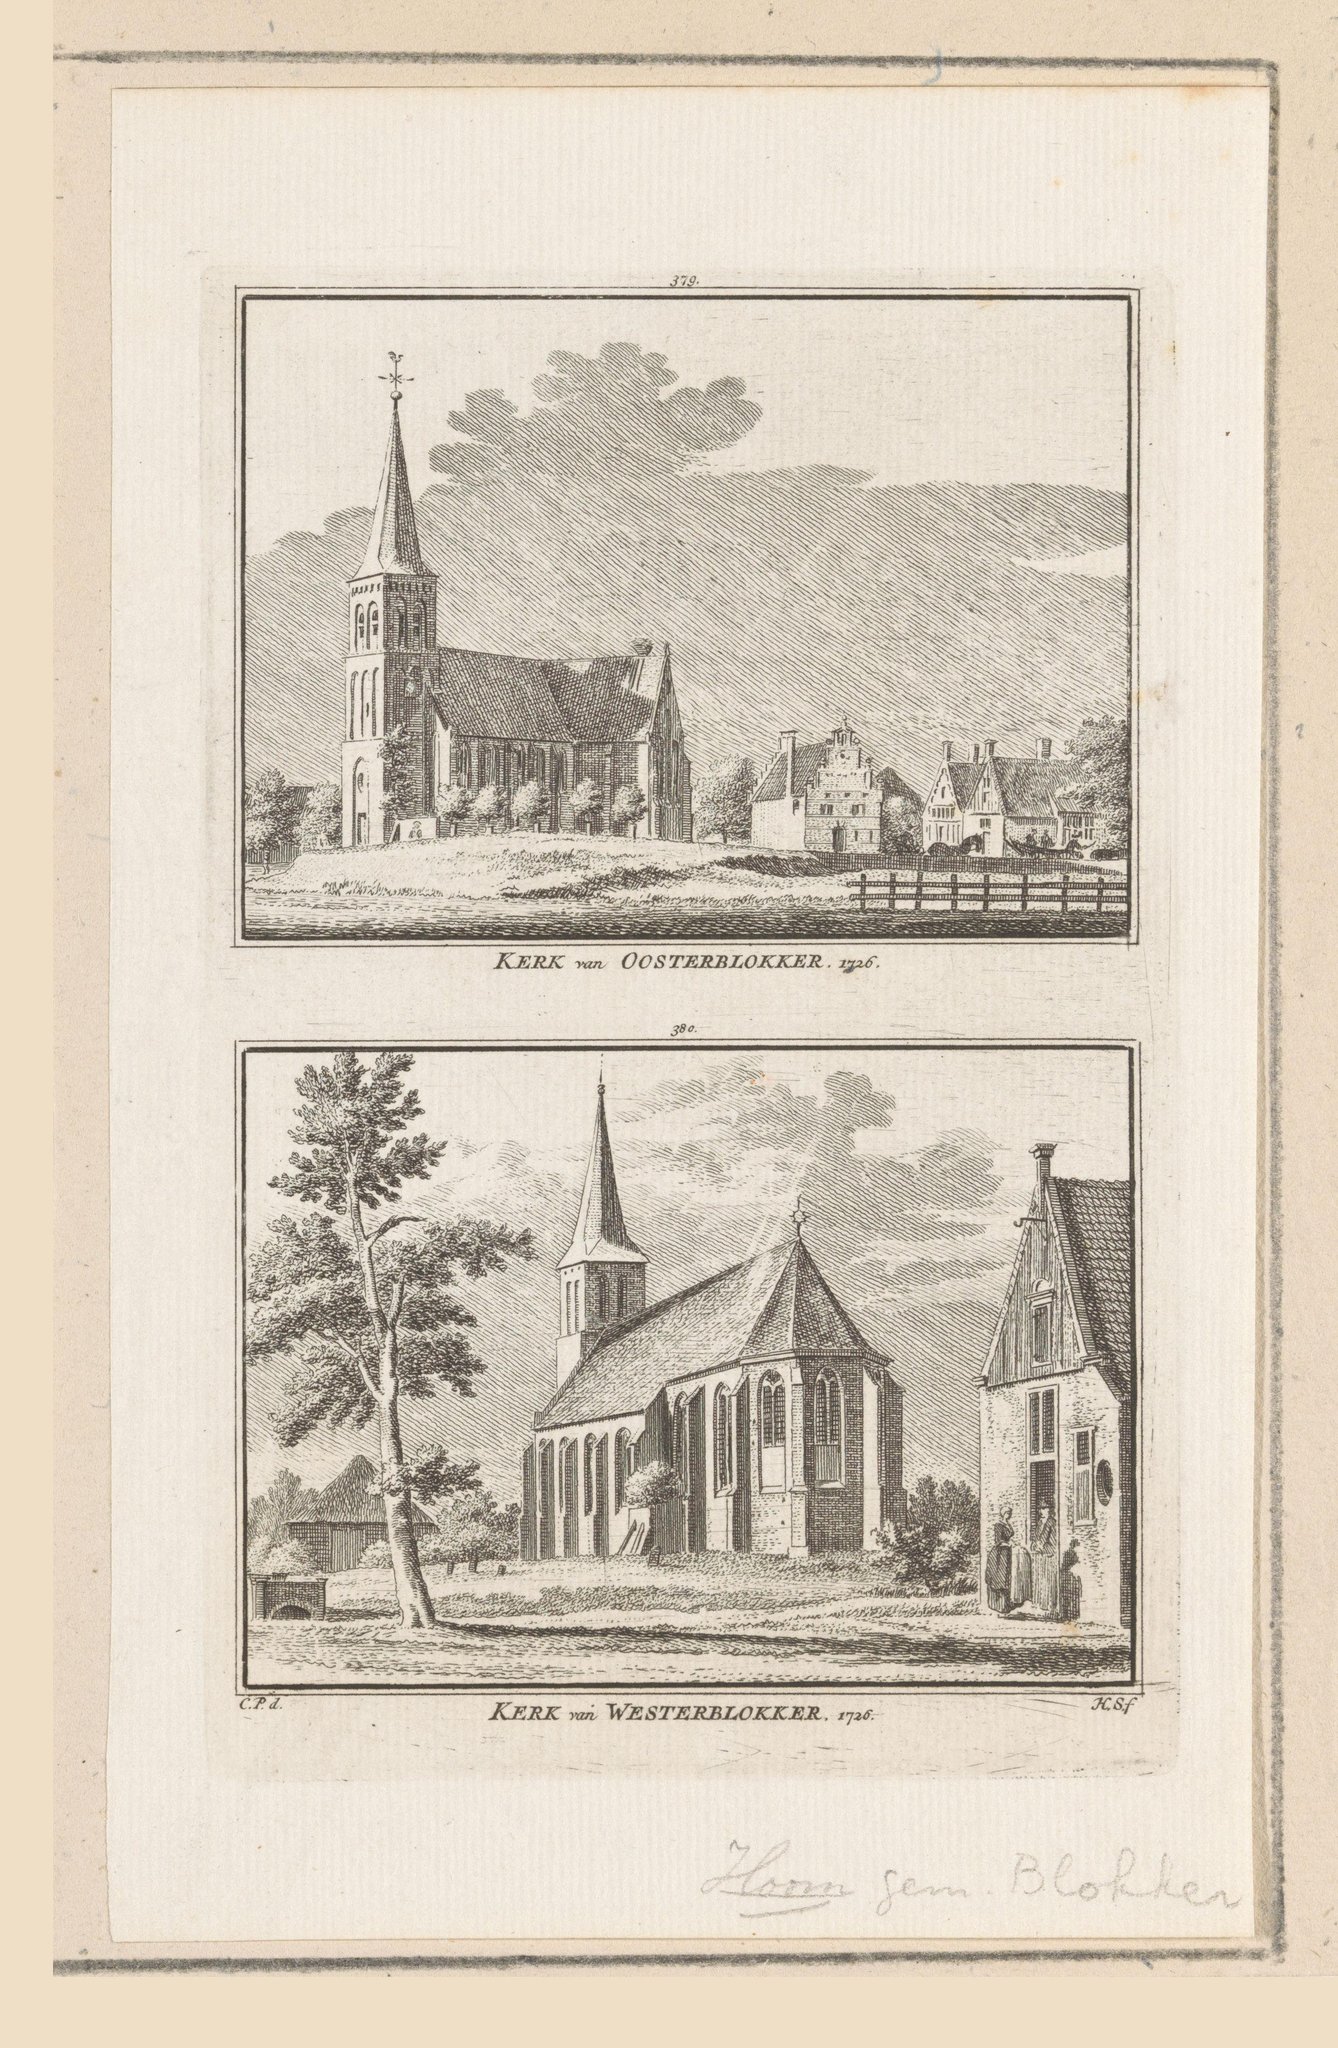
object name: book illustration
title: Kerk van Oosterblokker. 1726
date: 1752-1792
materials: paper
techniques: engraving, etching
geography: haarlem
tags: church (exterior), prospect of city, town panorama, silhouette of city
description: Prent ook gebruikt in: Het verheerlykt Nederland of kabinet van hedendaagsche gezigten van steden, dorpen (…). 9 delen. Amsterdam: Isaak Tirion en weduwe Isaak Tirion, 1745-1774, dl. 4 (1752), ill. 379 en 380. Of in: Nederlandsche tafereelen; of eene keurige verzameling van negen honderd fraaije gezigten van steden, dorpen, sloten, oudheden (….). 9 delen. Amsterdam: Jan de Groot, 1792, dl. 4, ill. 379 en 380. Uit welke druk het huidige exemplaar precies komt is niet na te gaan.